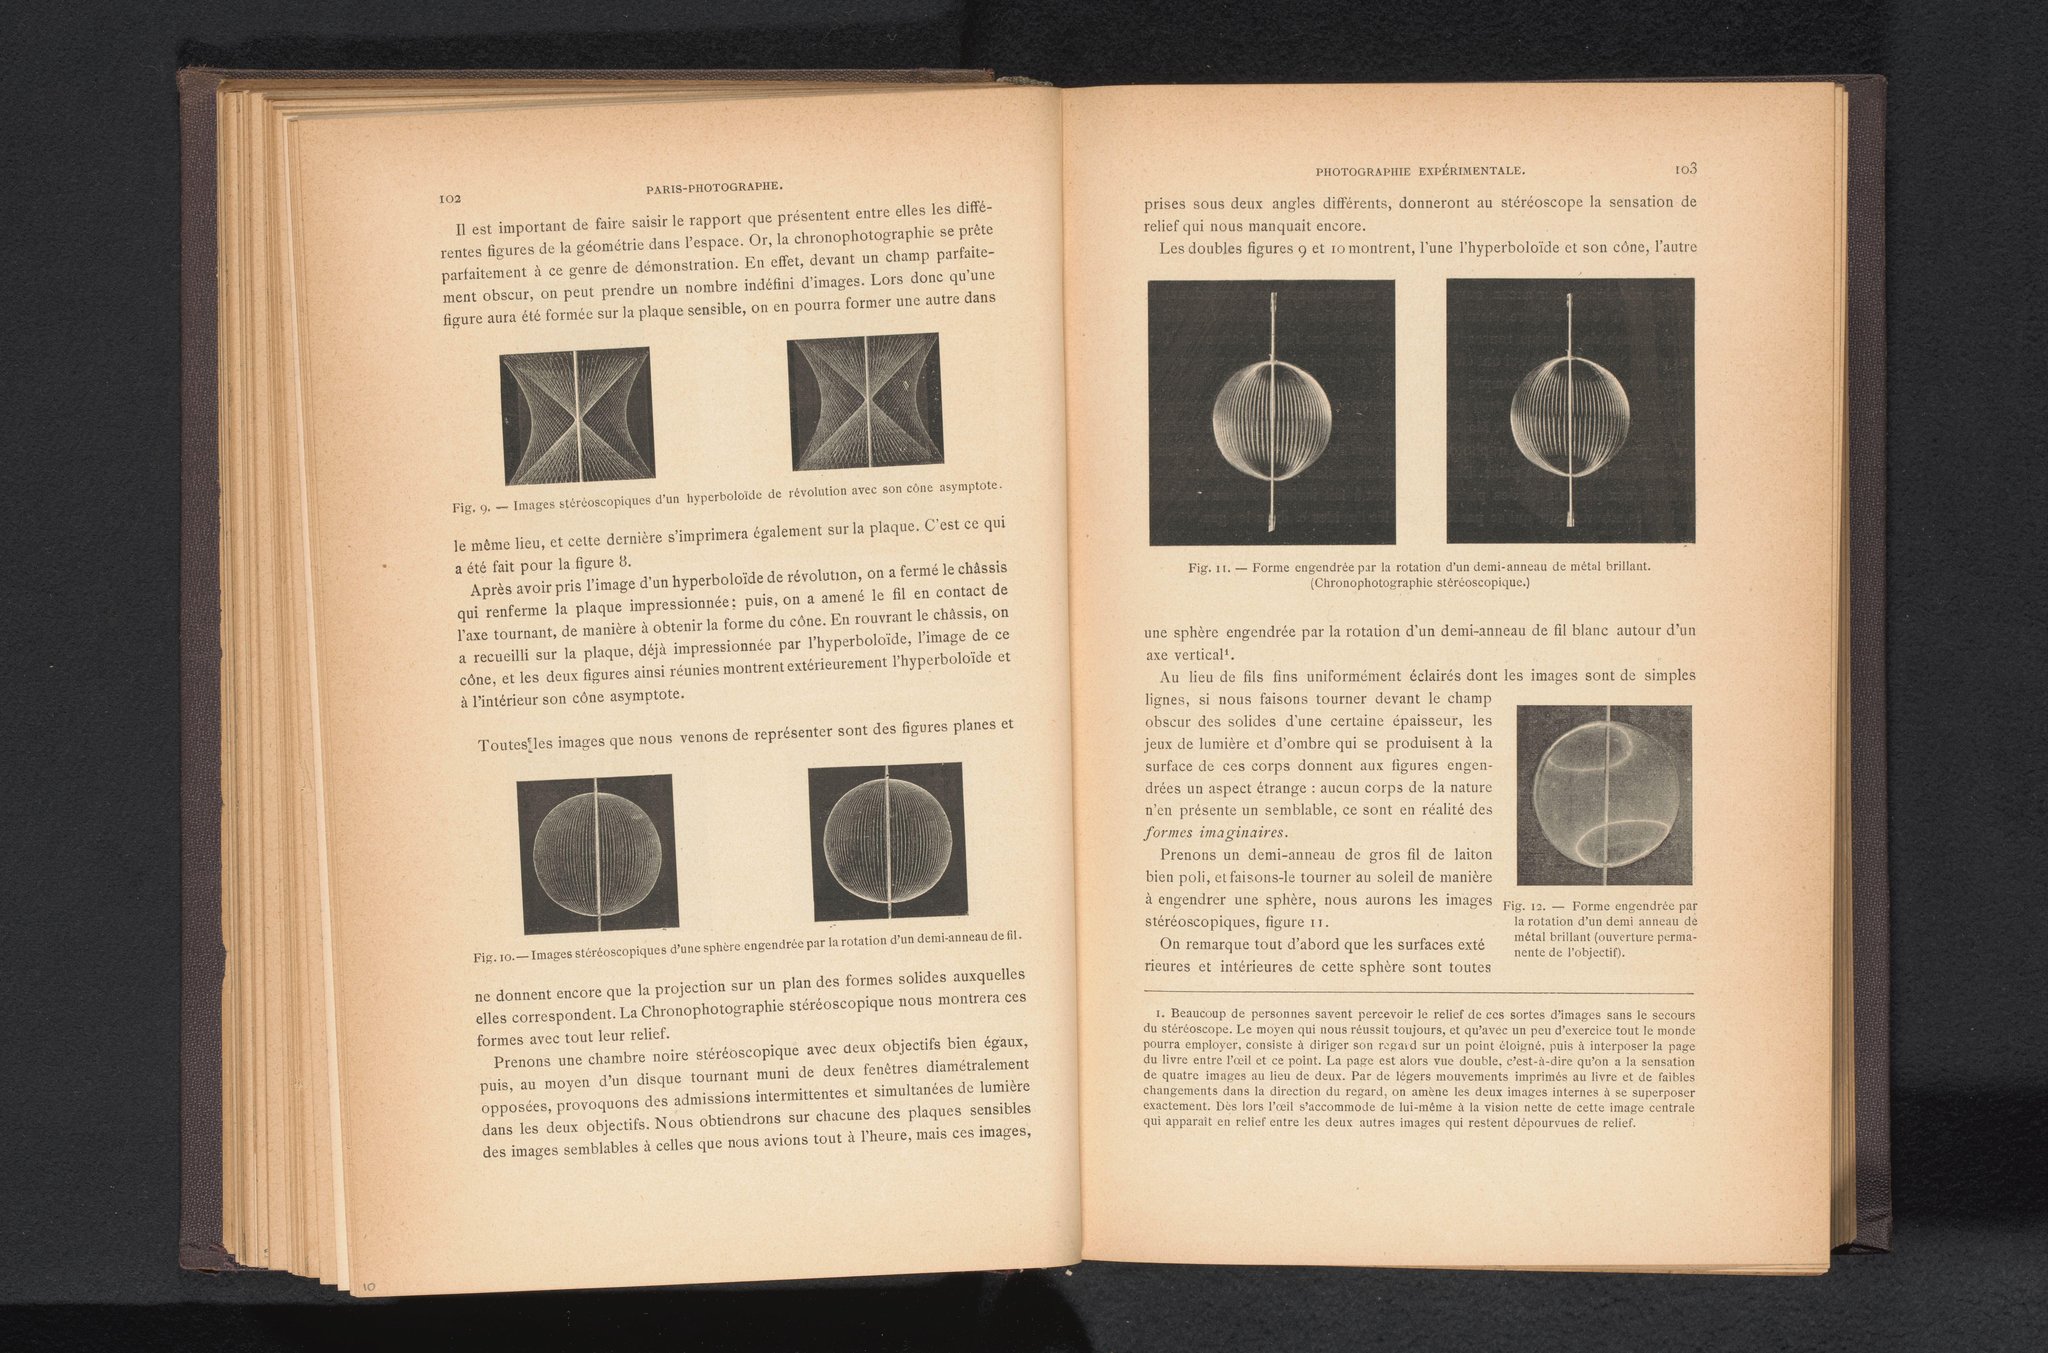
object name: page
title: Vier figuren ter verduidelijking van chronofotografie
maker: Anonymous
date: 1883-1893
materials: paper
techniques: autotype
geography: france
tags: first beginnings of photography and cinematography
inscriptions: inscription: ‘Images stéréoscopiques d'un hyperboloïde de révolution avec son cône asymptone. Images stéréoscopiques d'une sphère engendrée par la rotation d'un demi-anneau de fil.’, number: ‘Fig. 9. Fig. 10.’